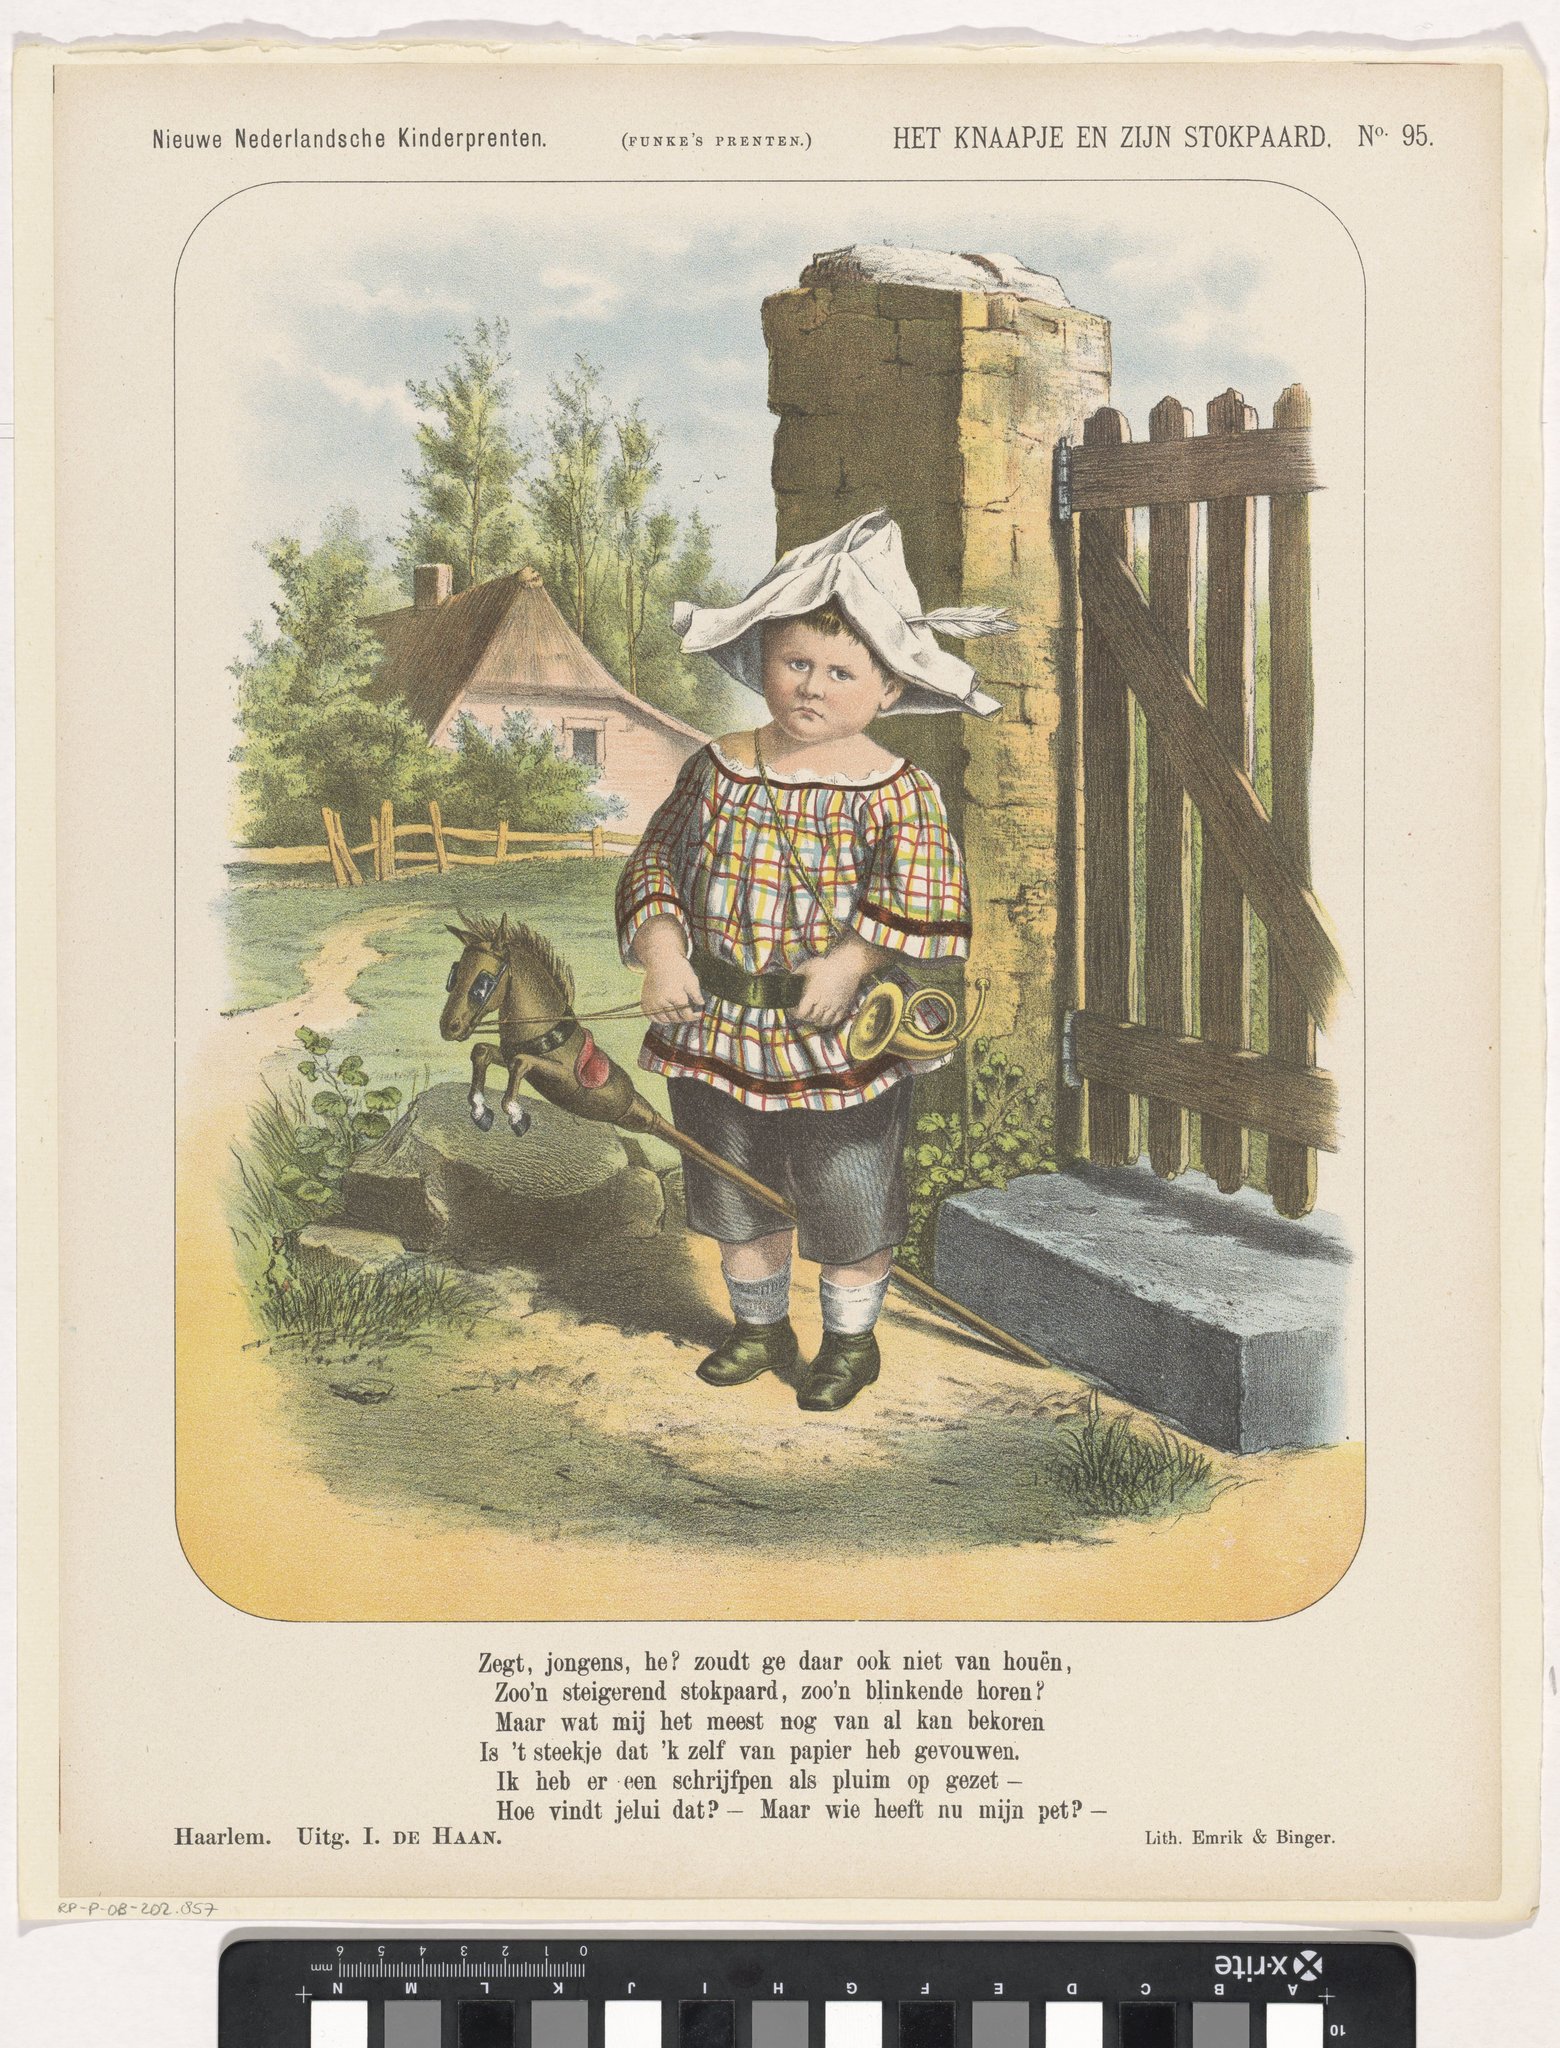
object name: popular print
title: Het knaapje en zijn stokpaard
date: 1875-1903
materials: paper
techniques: lithograph, letterpress printing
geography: haarlem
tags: head-gear: bicorne, bicorn (+ boys' clothes), hobby-horse, child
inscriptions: collector's mark: Lugt 2760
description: Blad met een grote voorstelling van een jongen met papieren steek en stokpaard, staand voor een hek. Onder de voorstelling een zesregelig vers. Genummerd rechtsboven: No. 95.